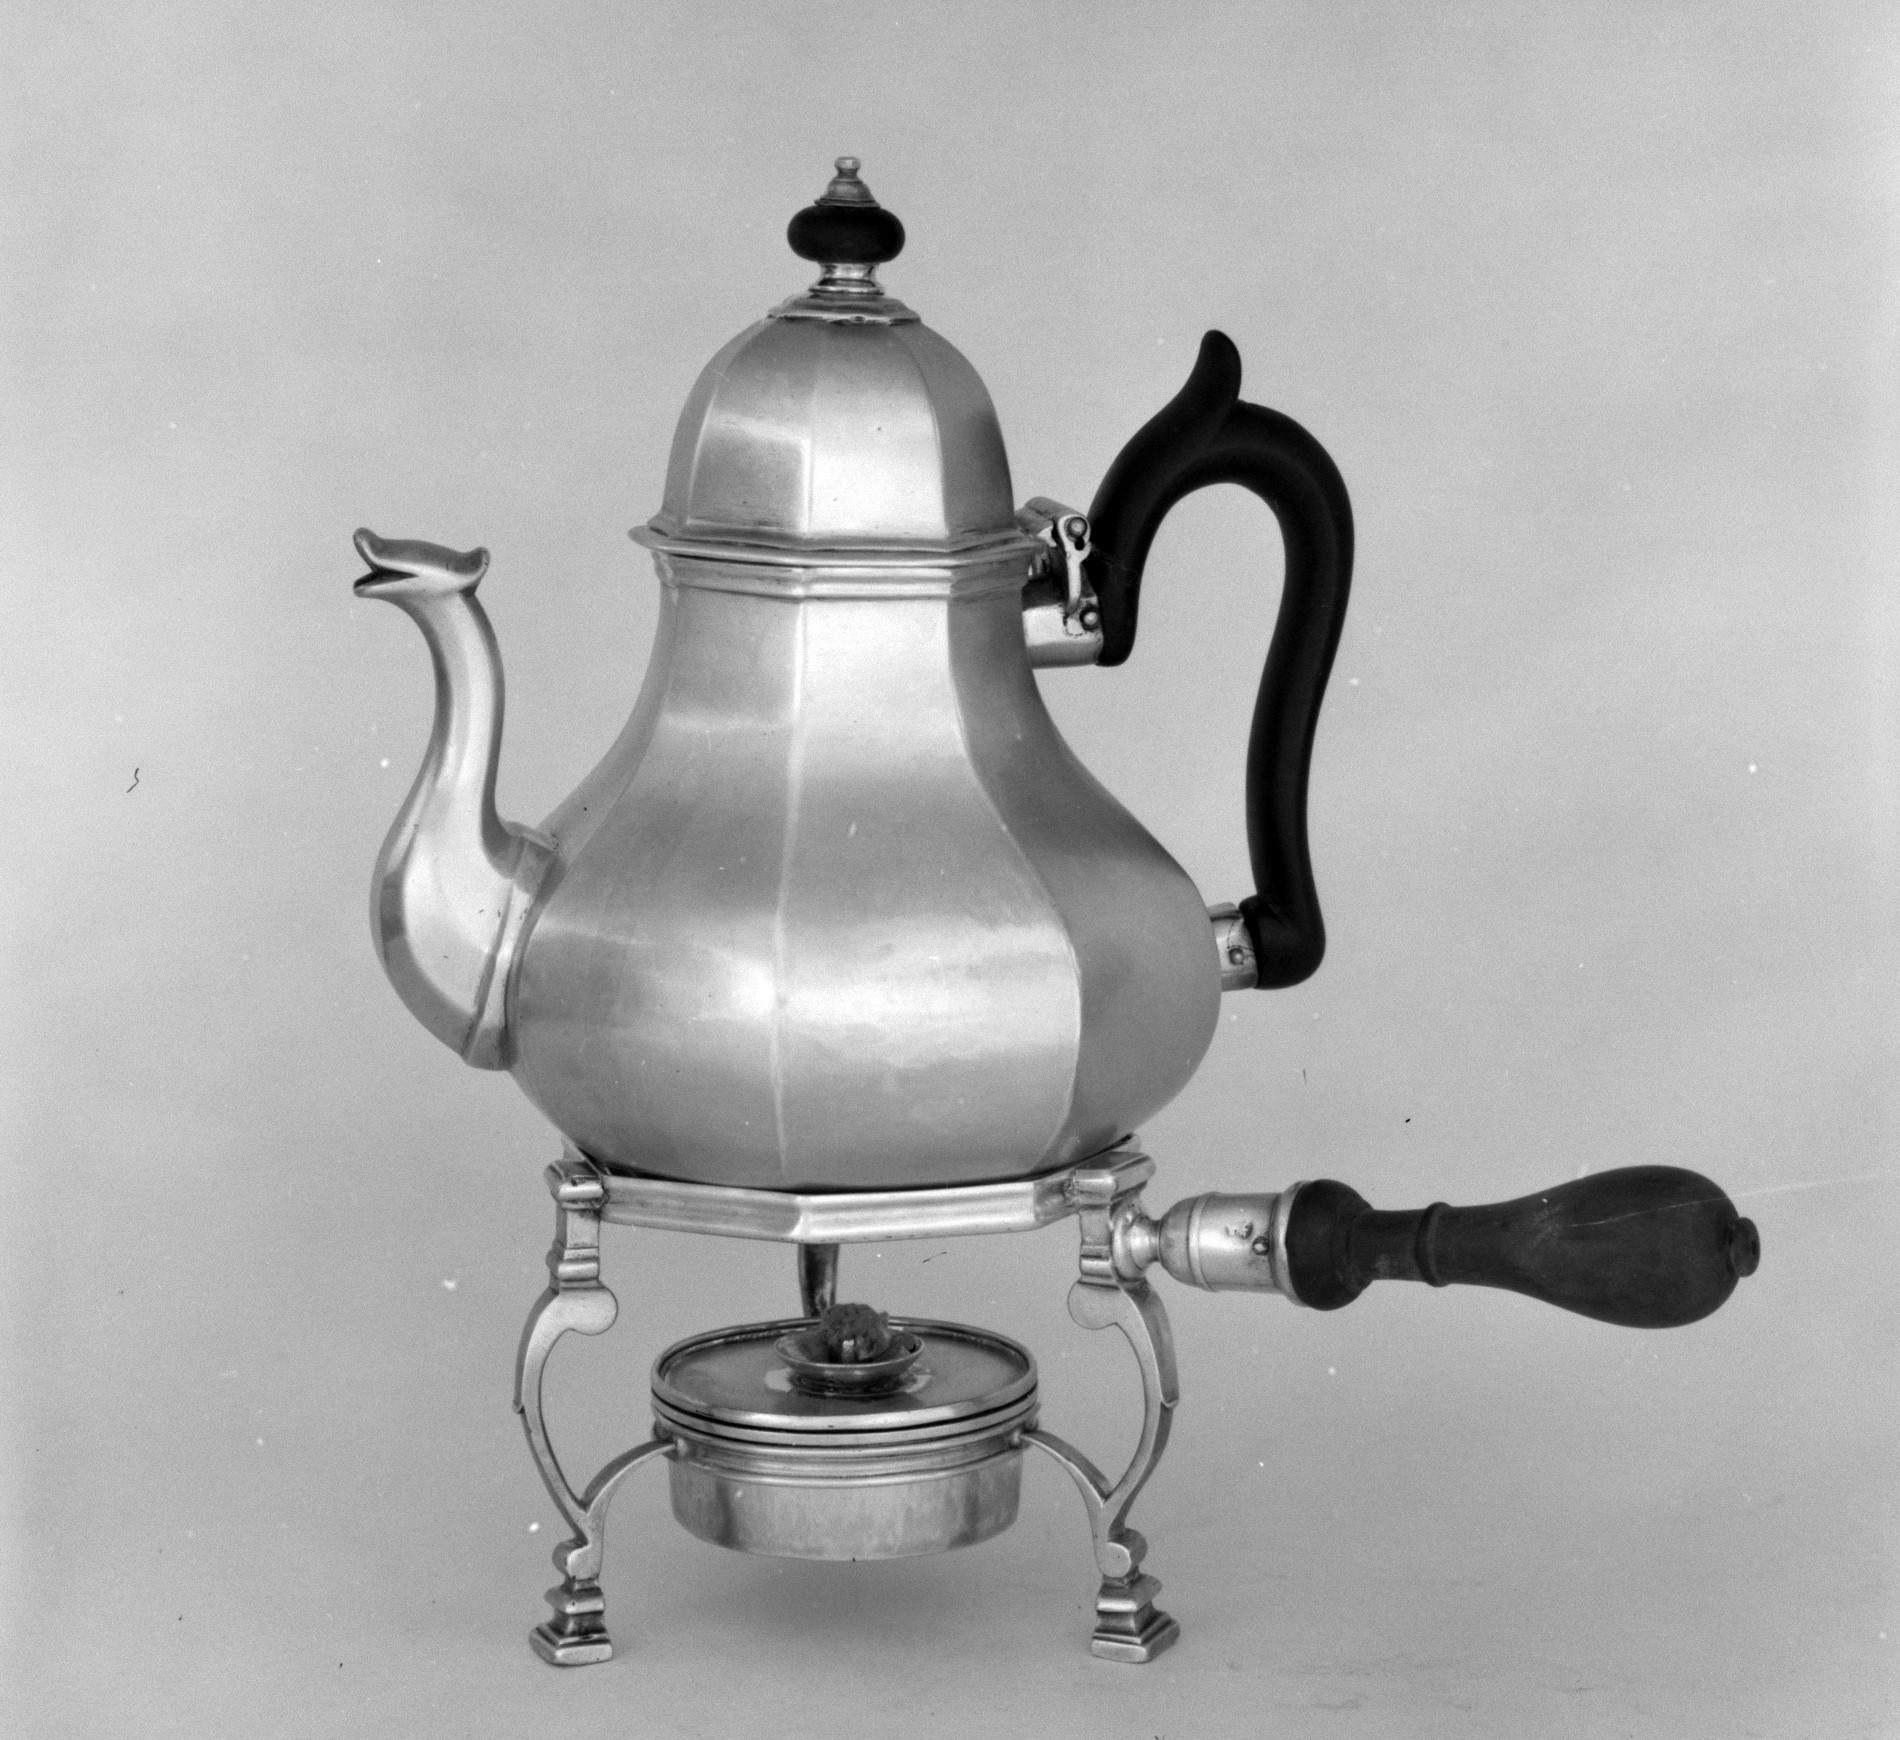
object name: teapot with lamp and lamp stand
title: Teapot with lamp and lampstand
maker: jonathan rand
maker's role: maker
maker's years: 1650-1750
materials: silver